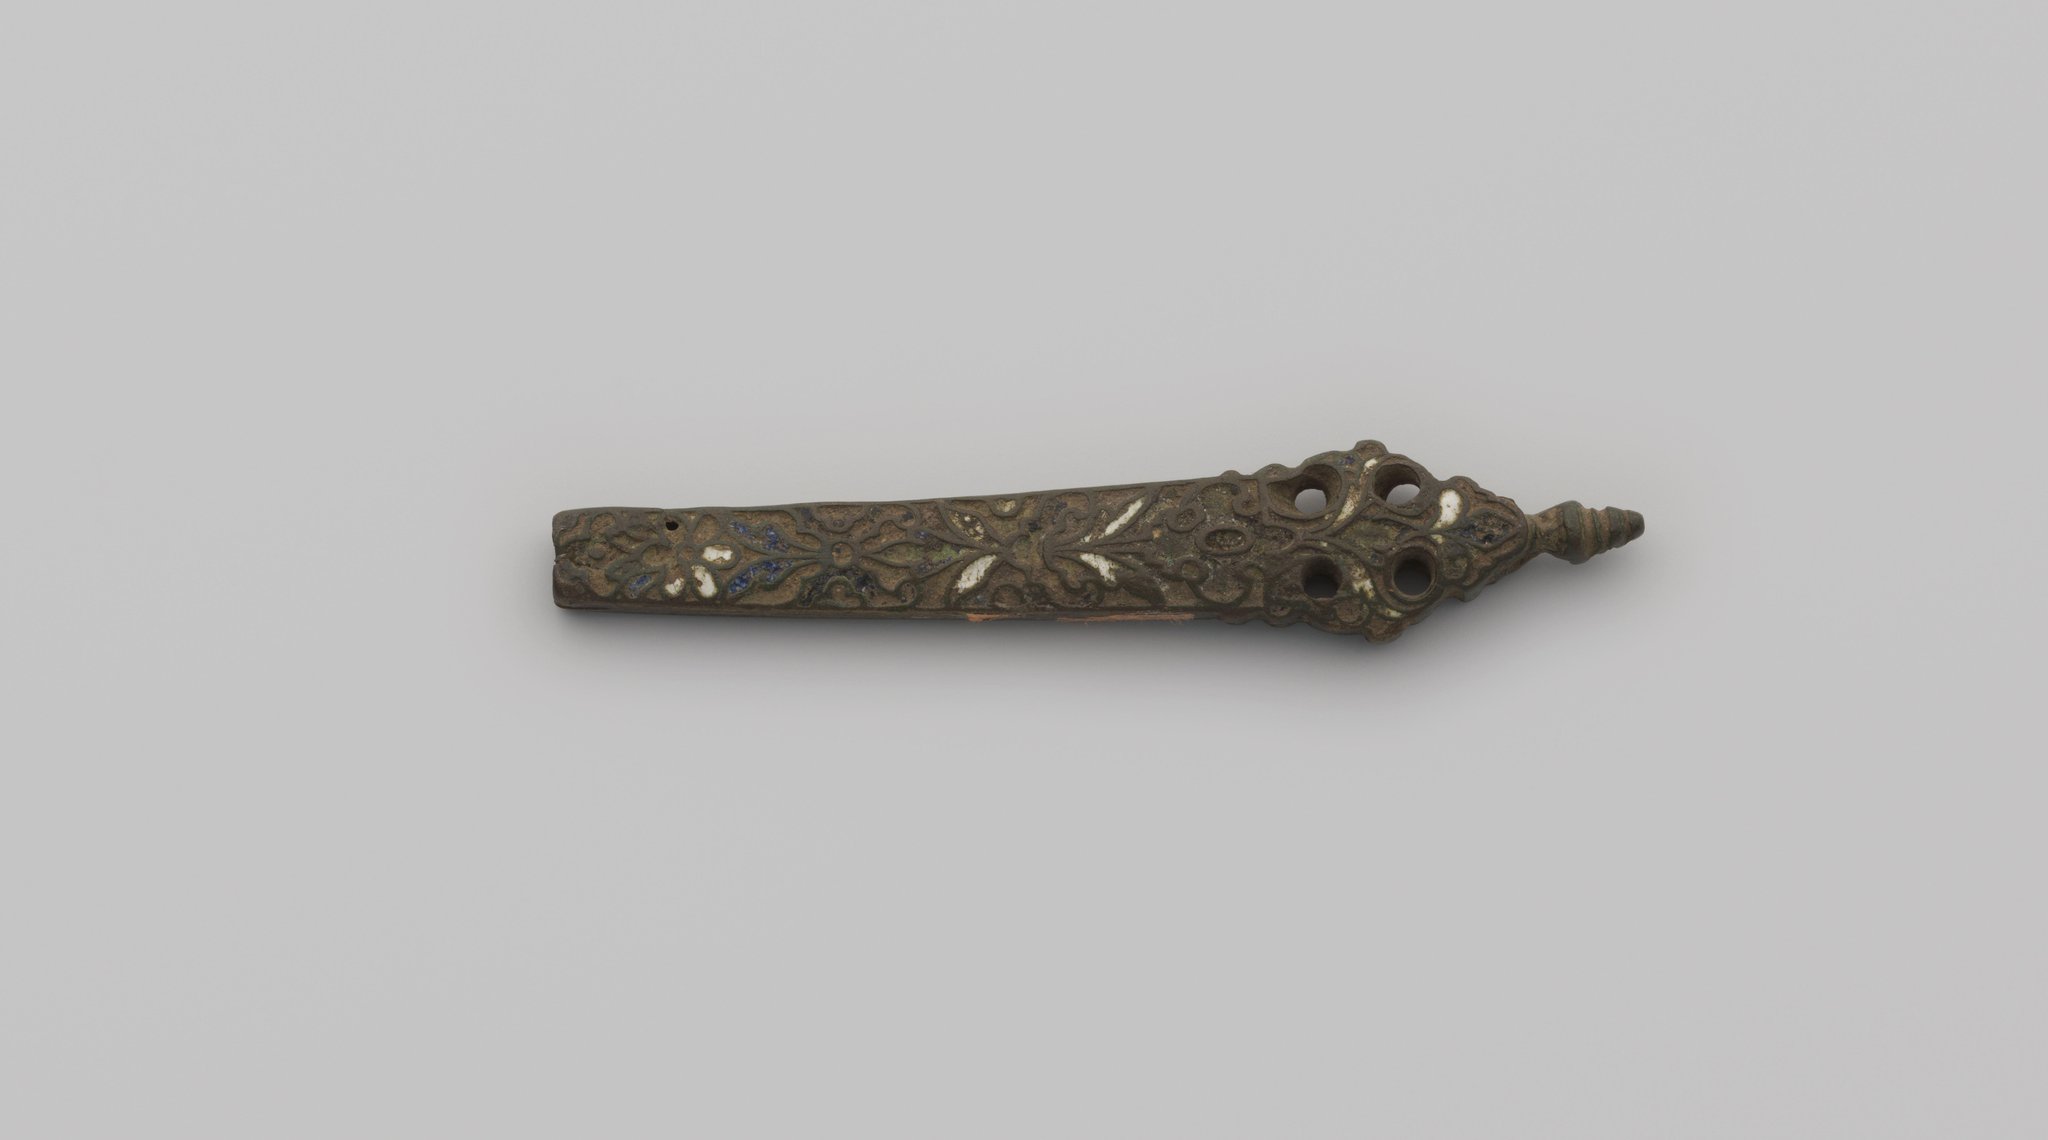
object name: haft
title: Messenheft met email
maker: Anonymous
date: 1575-1625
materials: copper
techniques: enamel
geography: netherlands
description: Messenheft van koper versierd met blad- en bloemmotieven van email. Het uiteinde is opengewerkt.